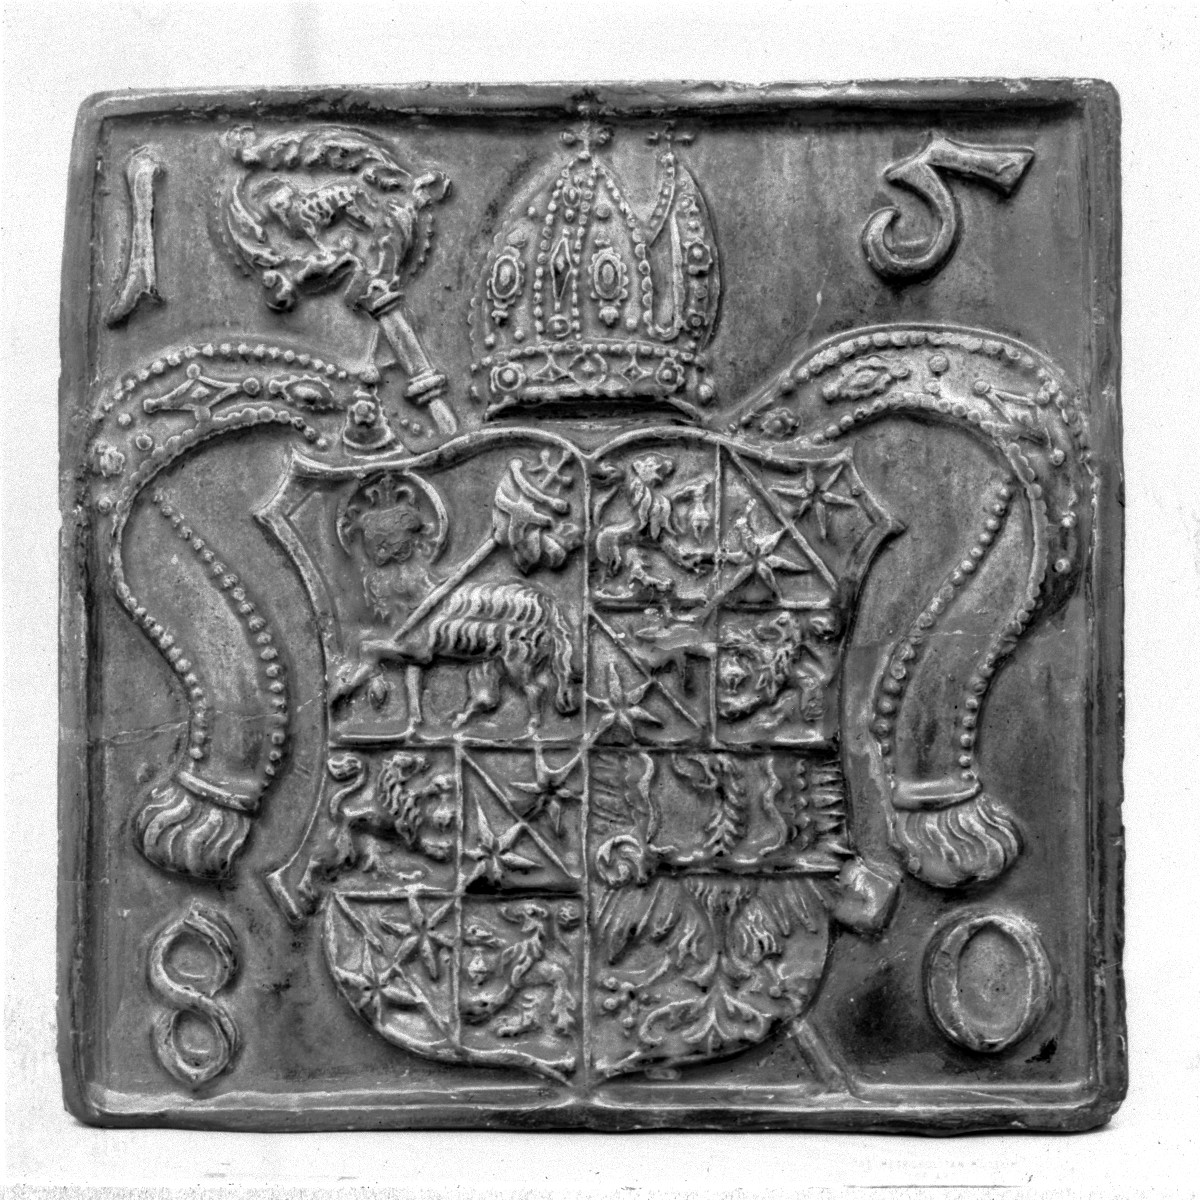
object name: tile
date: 1580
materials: earthenware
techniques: glazing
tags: animals,coat of arms